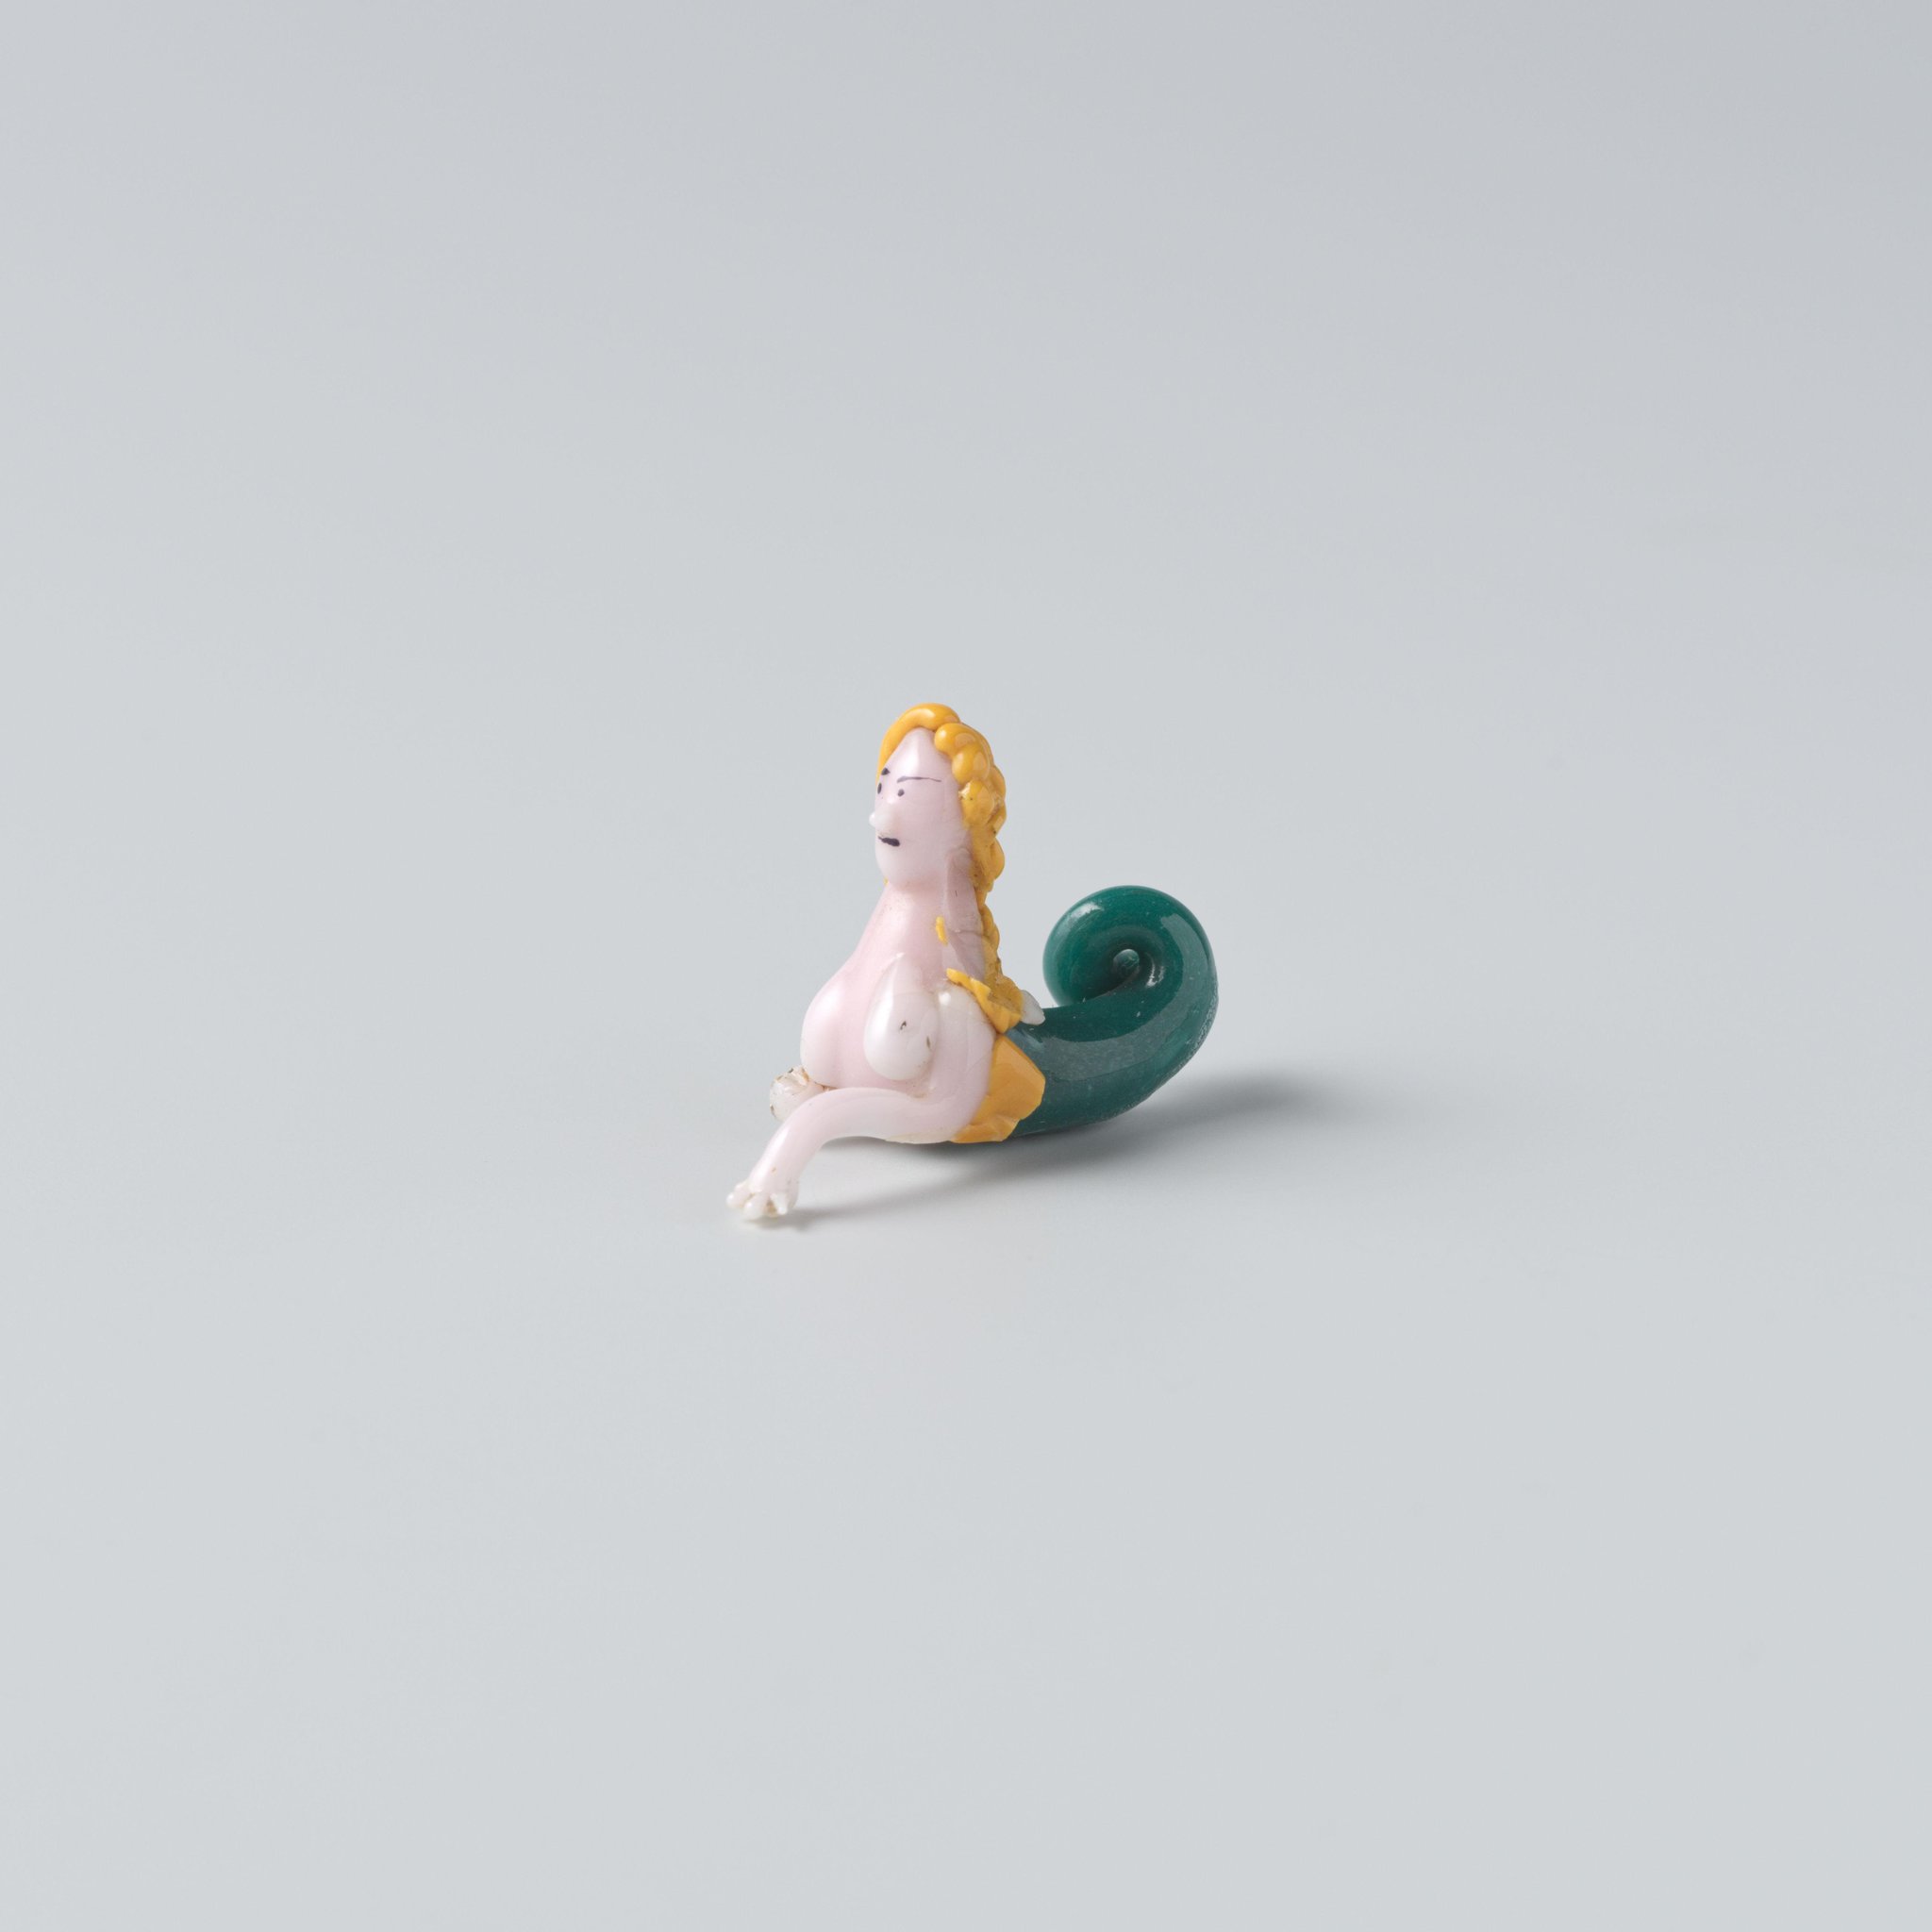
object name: miniature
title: Zeemeermin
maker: Anonymous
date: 1600-1699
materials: glass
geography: amsterdam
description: Zeemeermin, vervaardigd van glas, wit bovenlijf met lange 'blonde' haren en zwarte ogen, en groene vissestaart met krul.